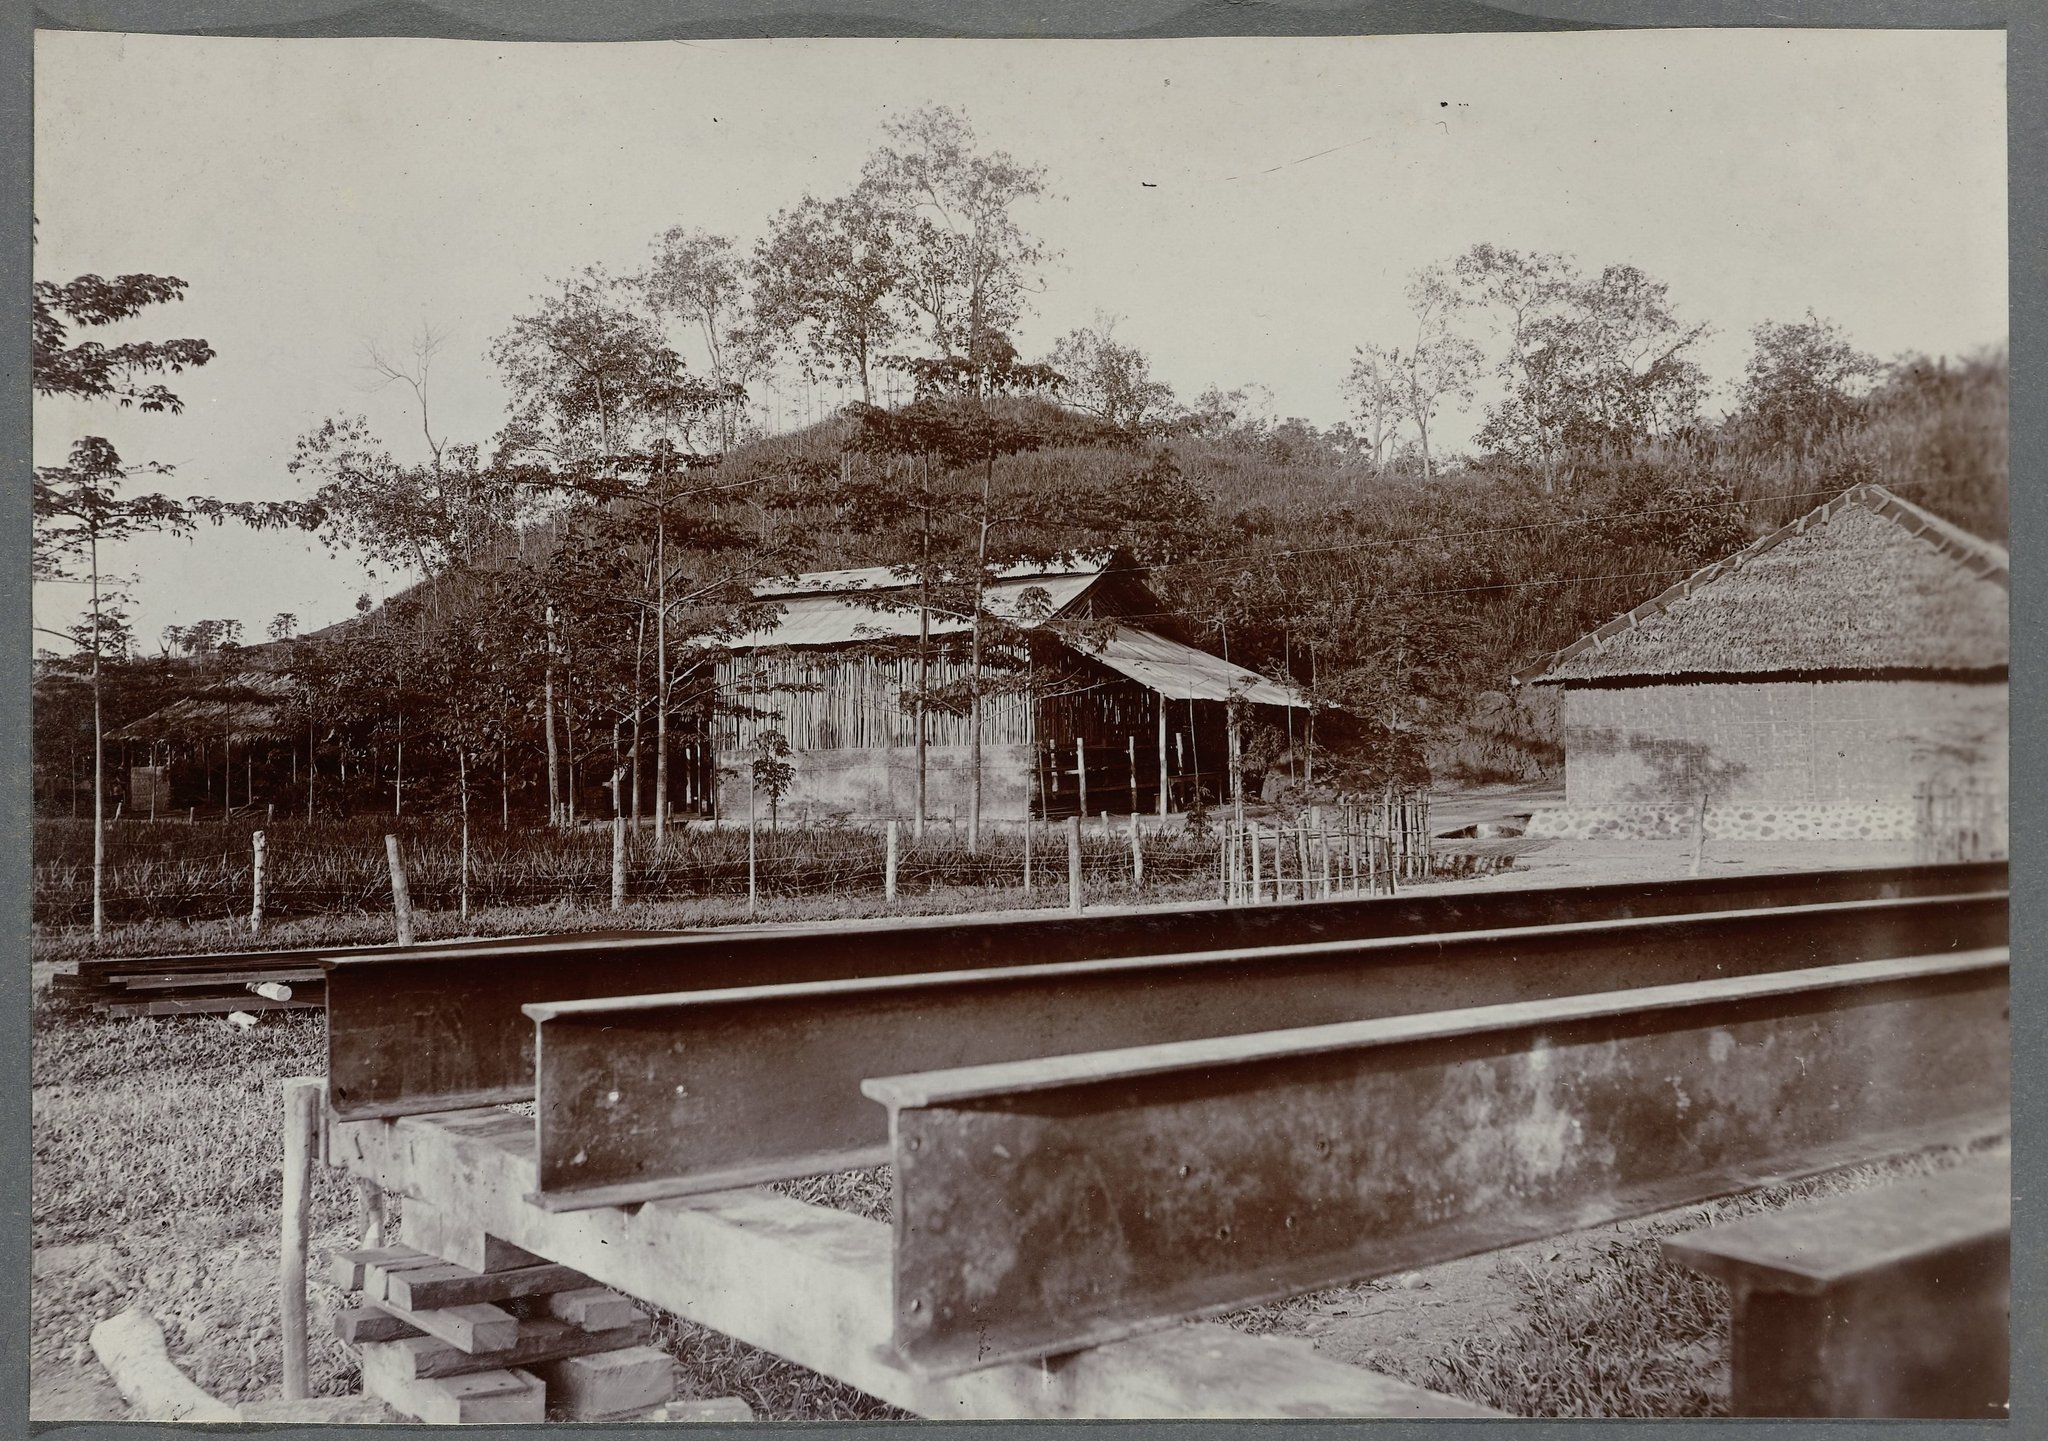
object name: photograph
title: Forge at Camp Krueng Seumpo with Components for a Bridge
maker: Anonymous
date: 1903-1913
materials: photographic support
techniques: gelatin silver print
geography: north sumatra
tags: arnhem, albertus dominicus laman trip, building activities, traffic by road or path with motor-vehicle, road, path, industries ~ metal, bridge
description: Na de expedities naar de Gajo- en Alaslanden o.l.v. Van Daalen (eerste tocht in 1901), werd hij in 1903 belast met voorbereiding van permanente vestiging van Nederlands gezag. Aanleg van een weg van de Noordkust naar het binnenland was hierbij van groot belang. Deze zgn. Gajoweg werd aangelegd tussen 1903 en 1914, van Bireuen aan de kust naar Takinguen aan het bergmeer Danau Lauttawar, totale lengte 104 km.